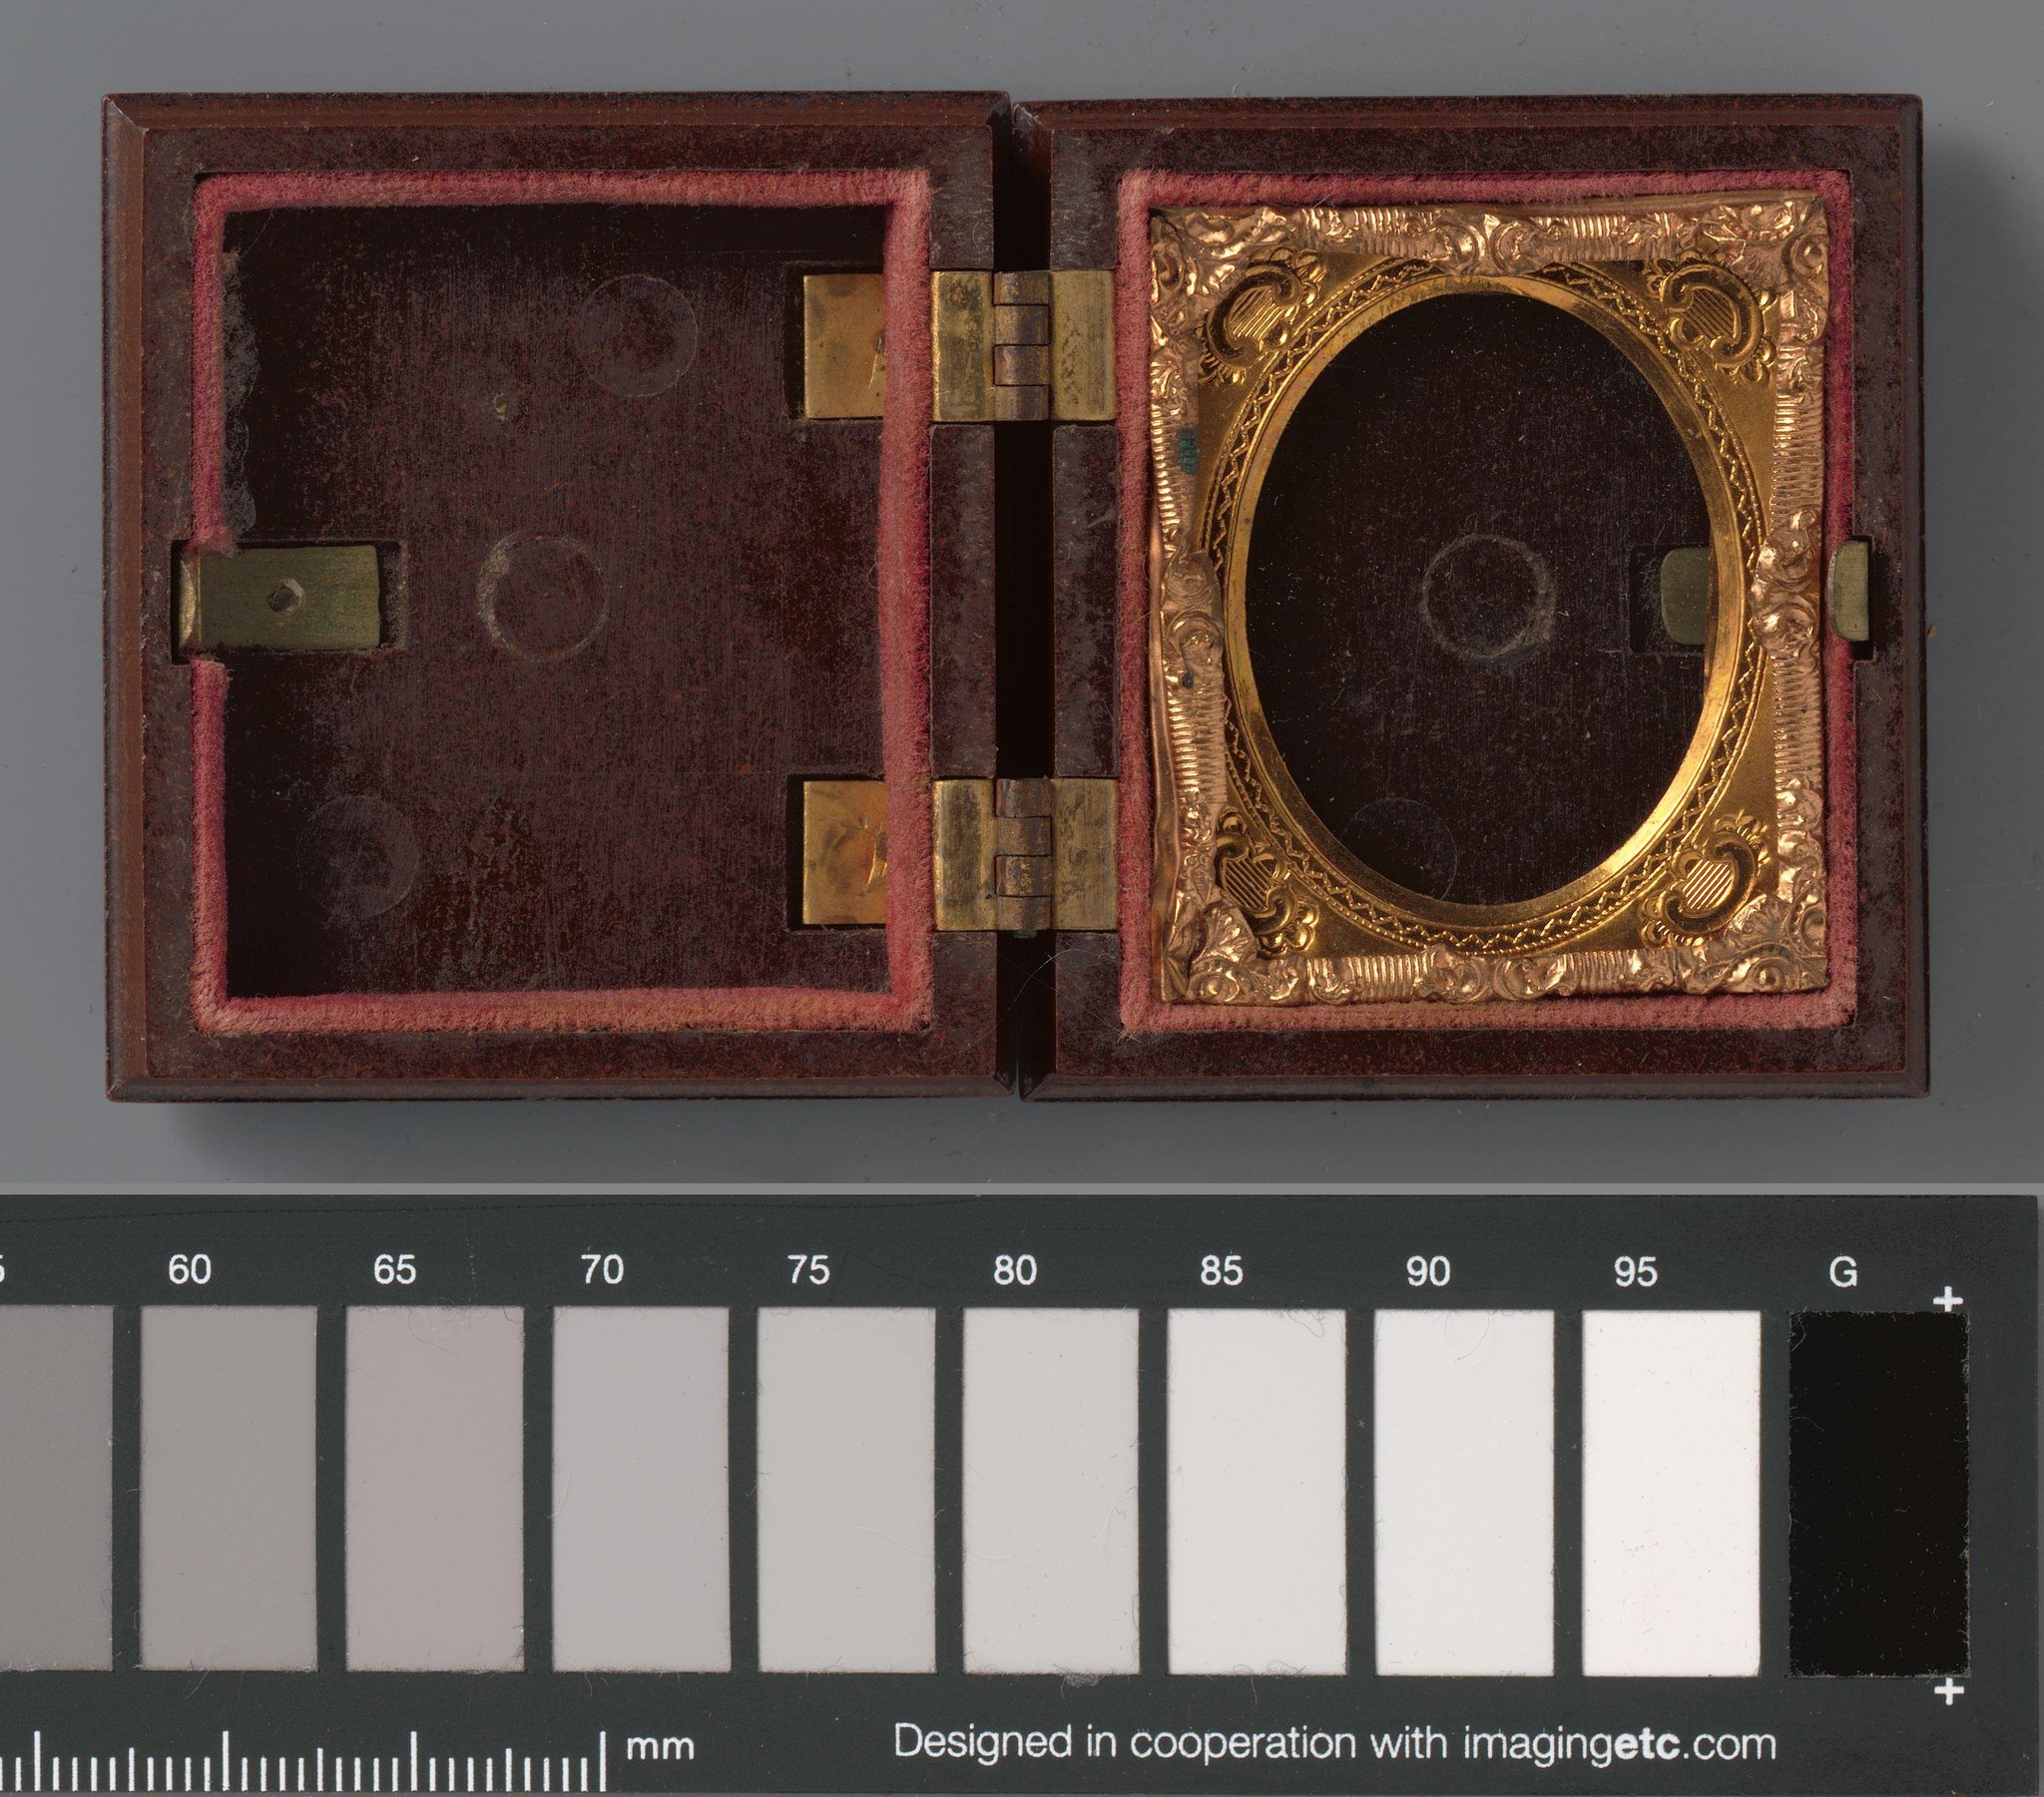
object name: union case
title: Lege union case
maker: Anonymous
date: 1855-1870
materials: glass, metal, plastic, velvet